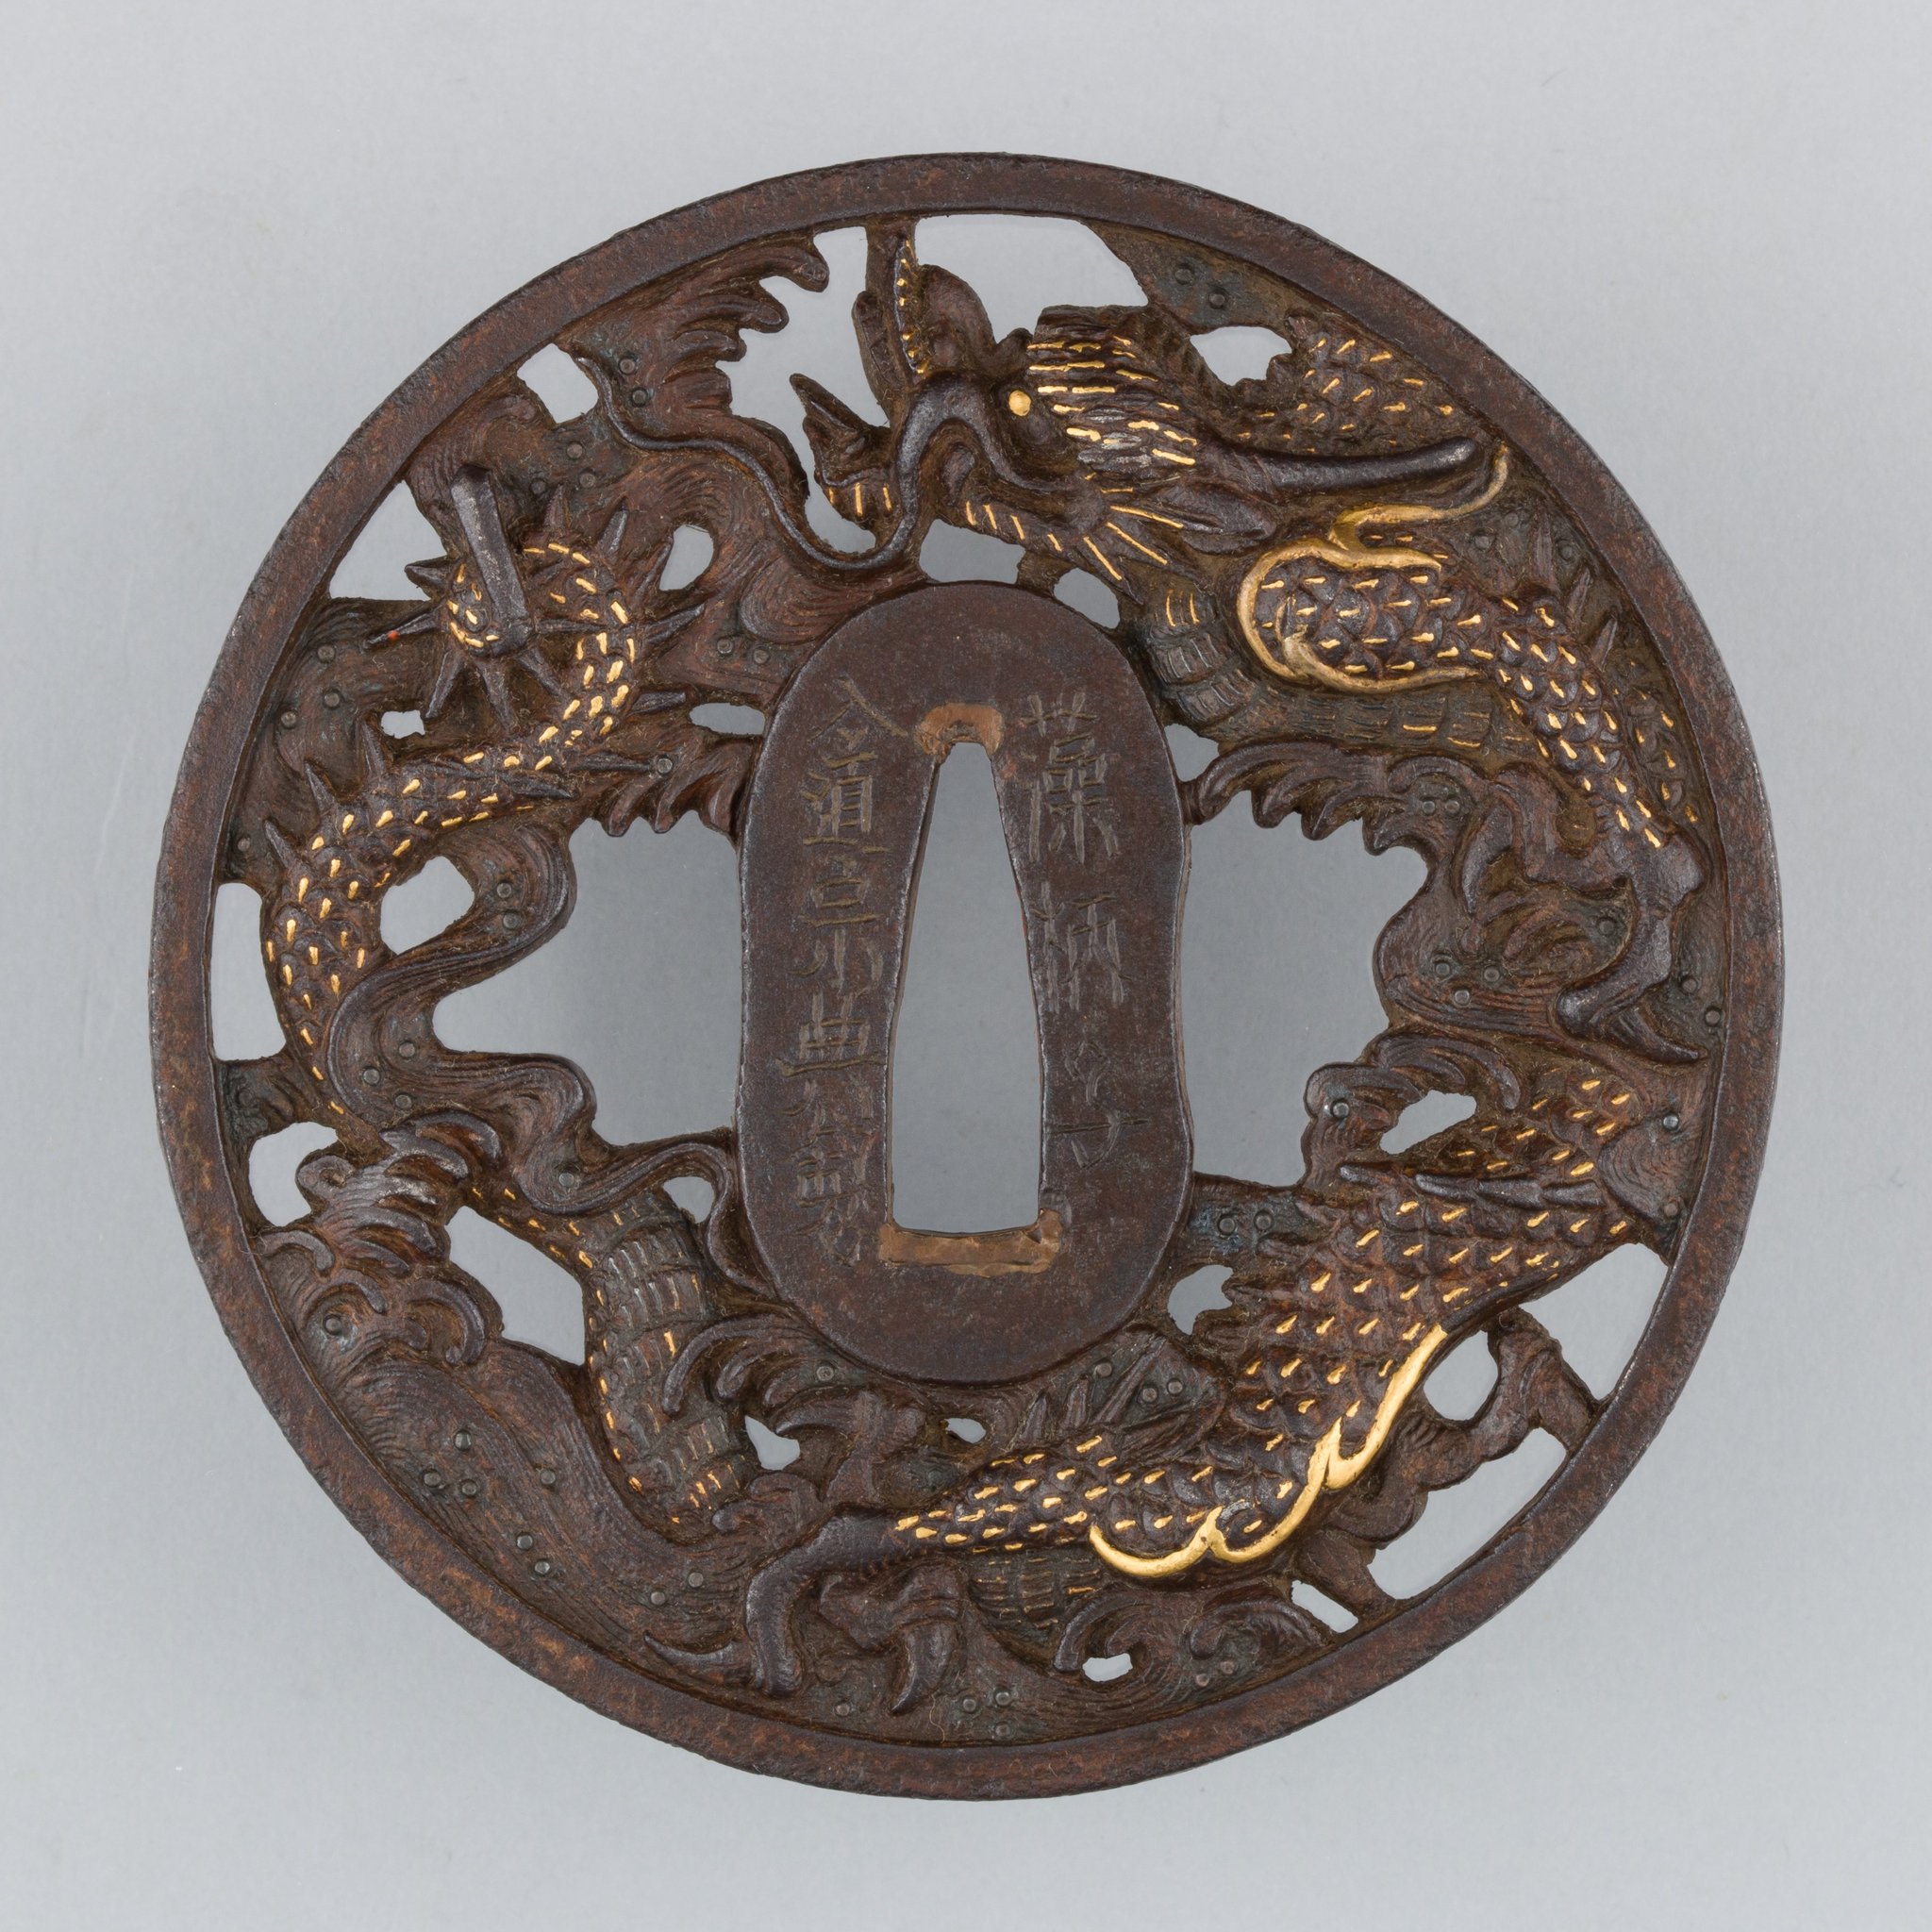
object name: sword guard tsuba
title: Sword Guard (Tsuba)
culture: japanese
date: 1667-1700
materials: copper, gold, iron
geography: japan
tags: dragons